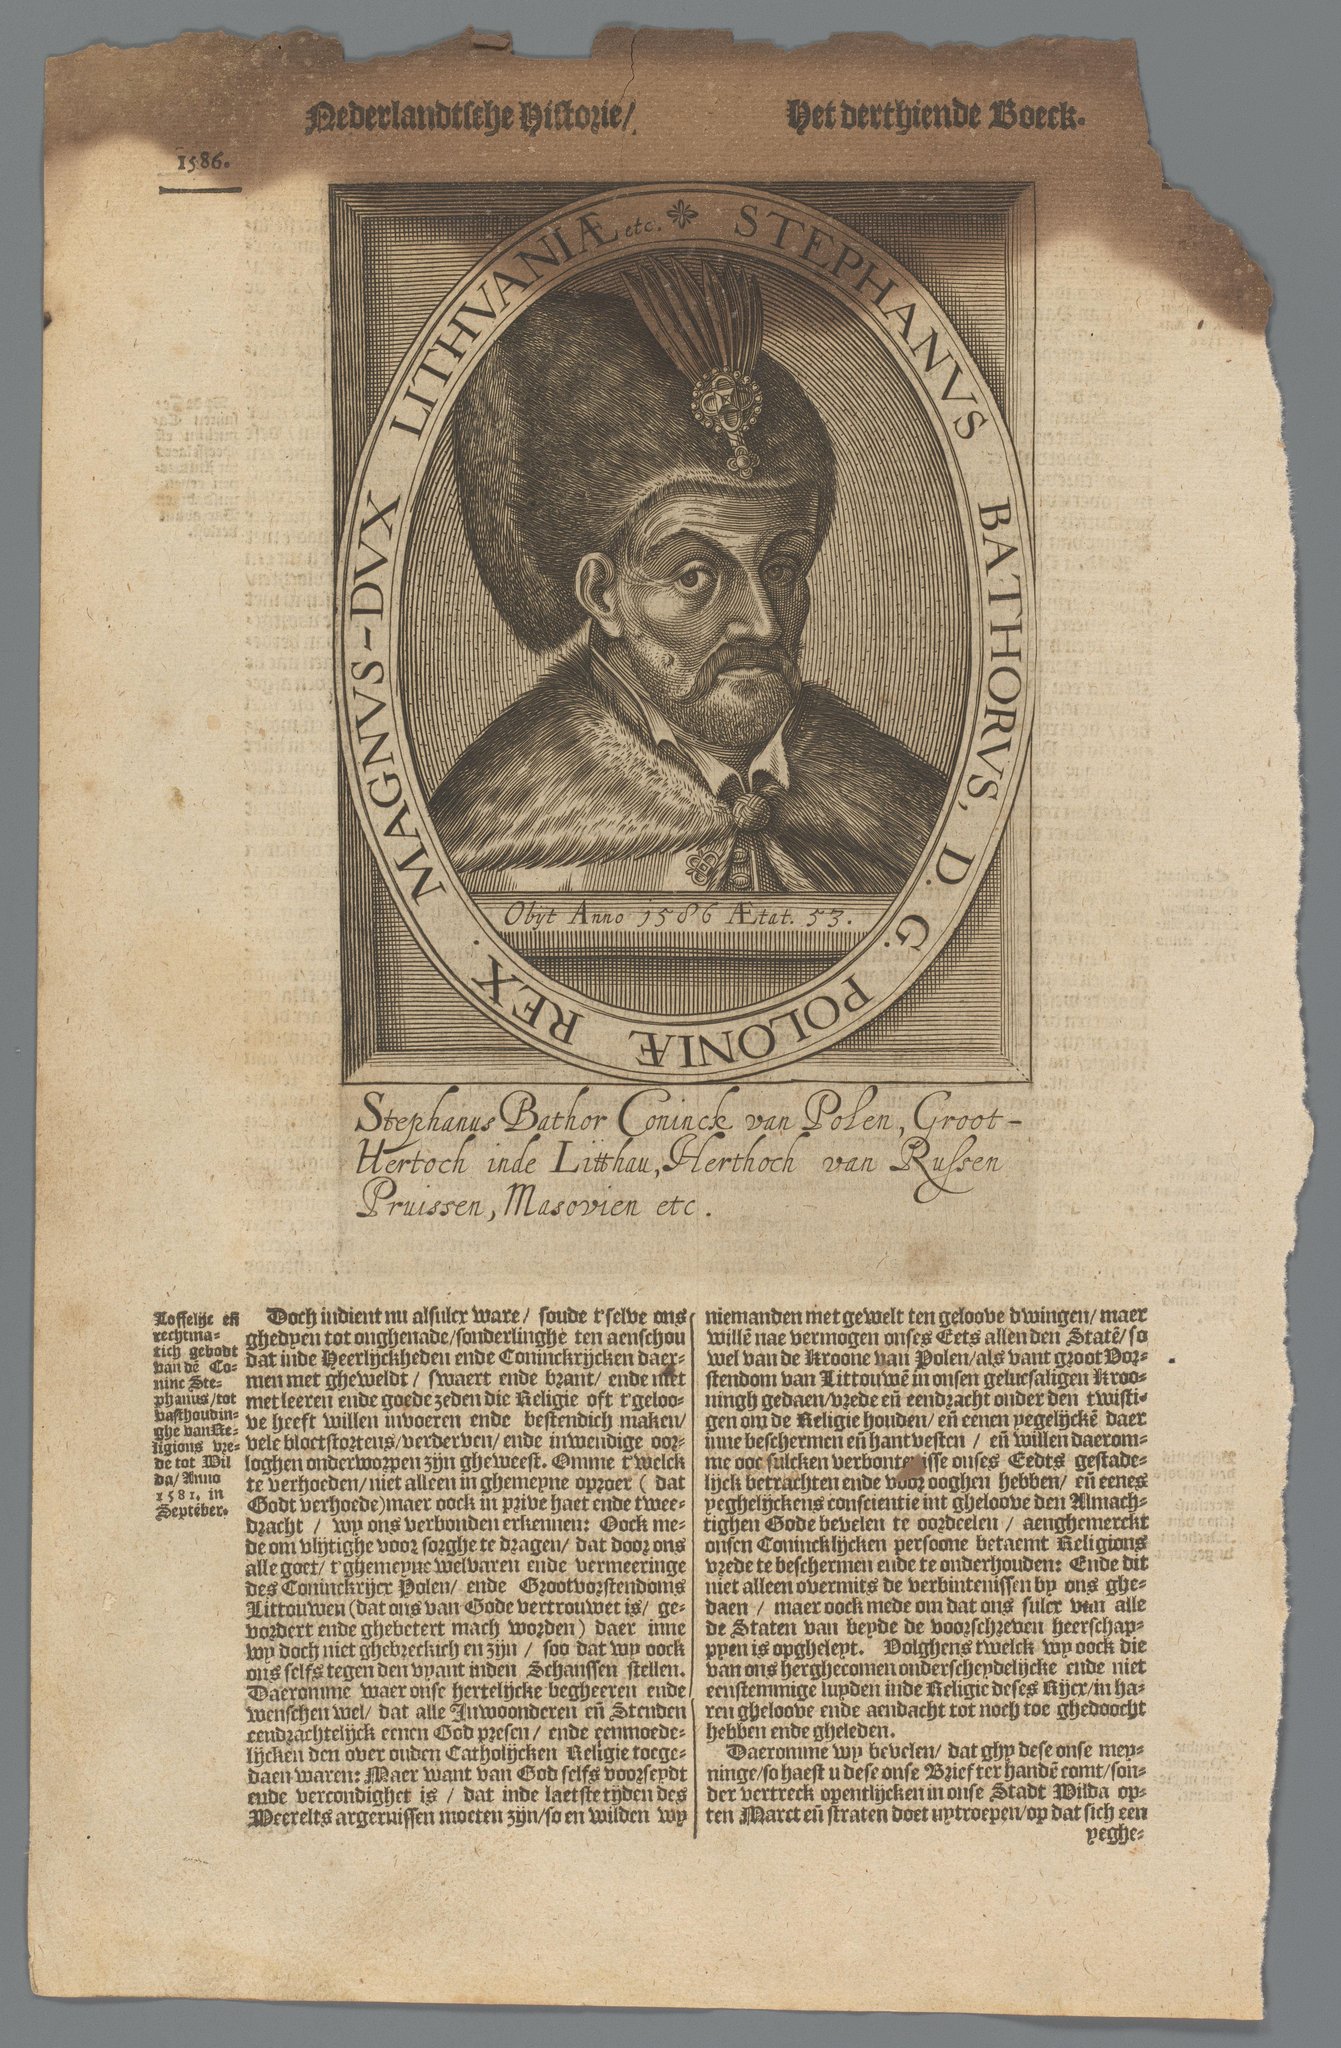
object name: book illustration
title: Stephanus Bathorus, d.g. Poloniae rex. magnus-dux Lithuaniae etc.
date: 1614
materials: paper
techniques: engraving, letterpress printing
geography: the hague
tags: historical persons, king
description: Prent uit: Meteren, Emanuel van. Historie der Nederlandscher ende haerder na-buren oorlogen ende geschiedenissen (...). Den Haag: Hillebrant Iacobsz. van Wouw, 1614.